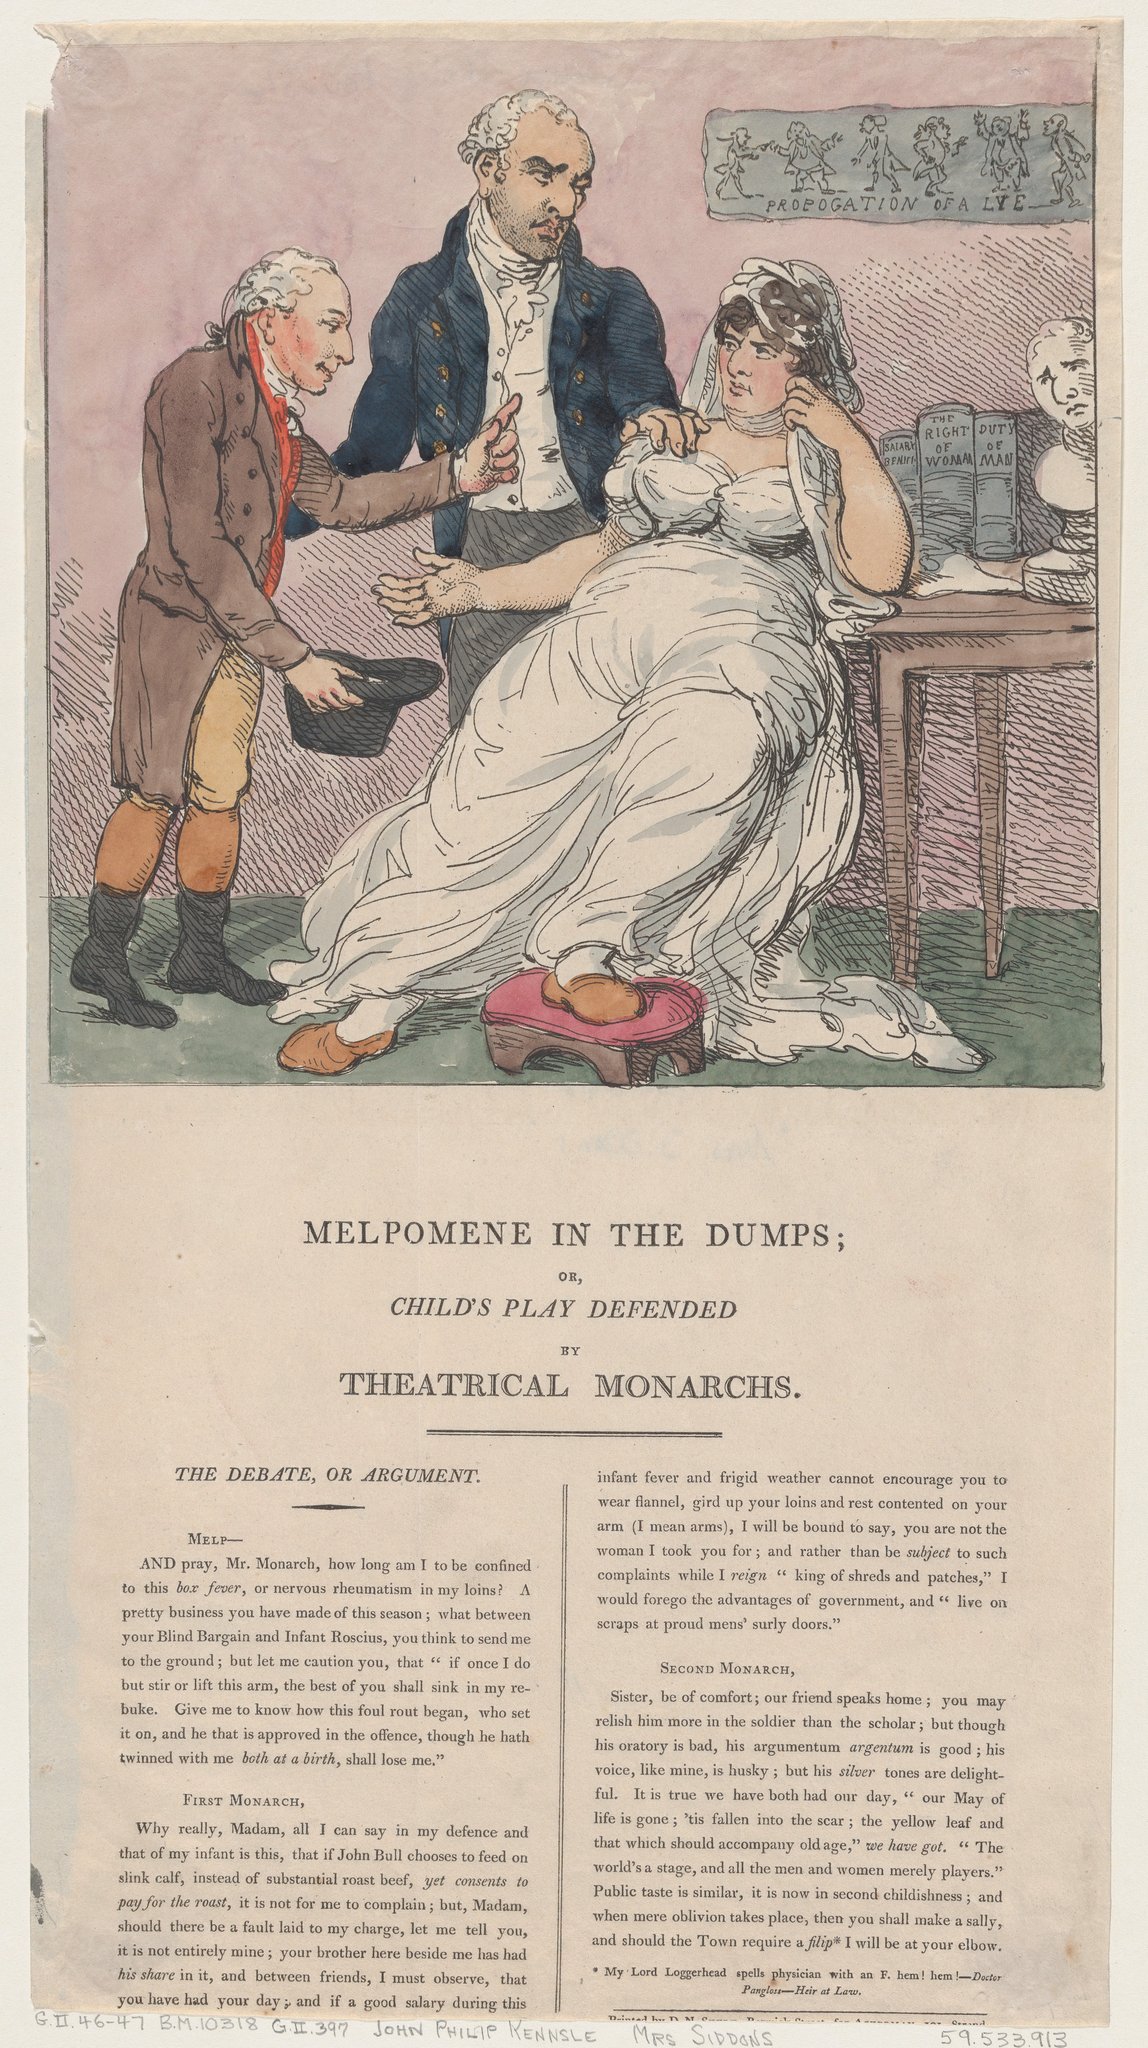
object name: print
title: Melpomene in the Dumps, or Child's Play Defended by Theatrical Monarchs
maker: thomas rowlandson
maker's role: artist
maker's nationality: british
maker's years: 1757-1827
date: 1804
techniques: etching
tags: satire,men,women,actresses